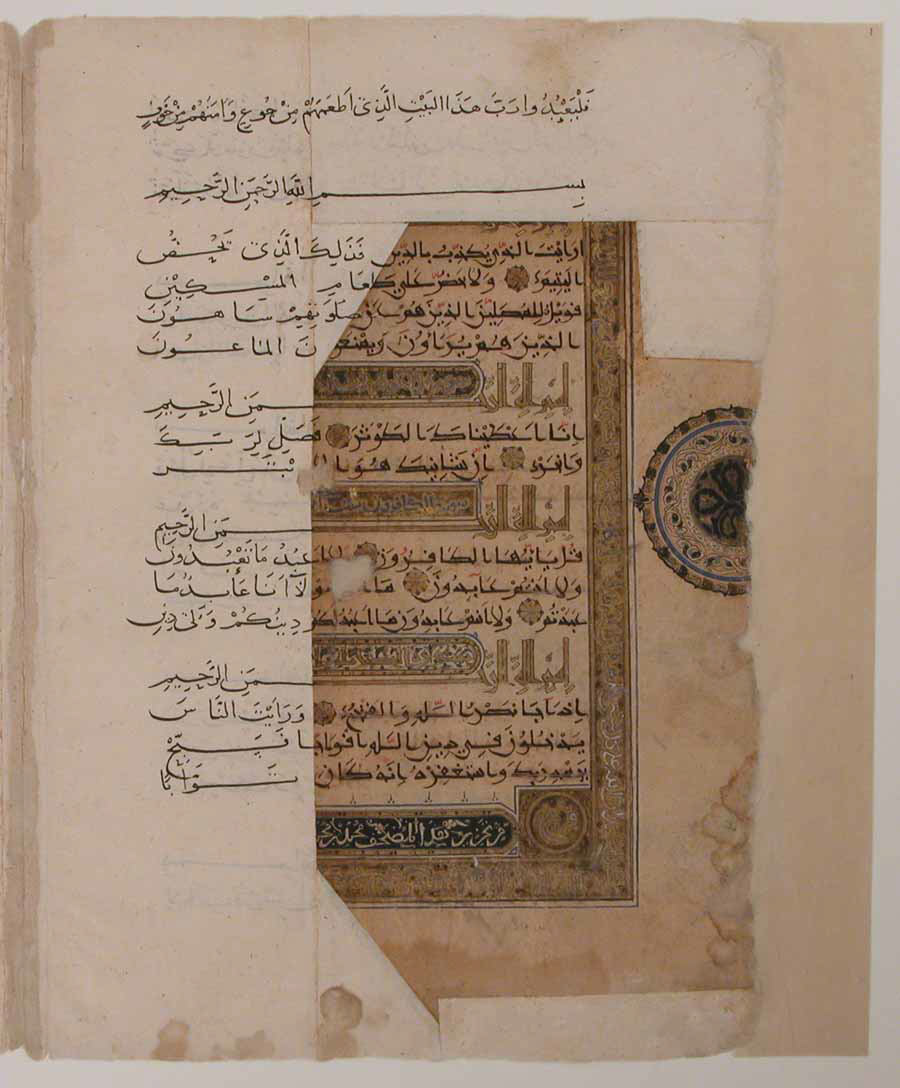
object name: folio from a non illustrated manuscript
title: Folio from a Qur'an Manuscript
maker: muhammad al-zanjani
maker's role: calligrapher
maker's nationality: iranian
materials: gold, ink, paper, watercolor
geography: iran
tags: qur'an,calligraphy